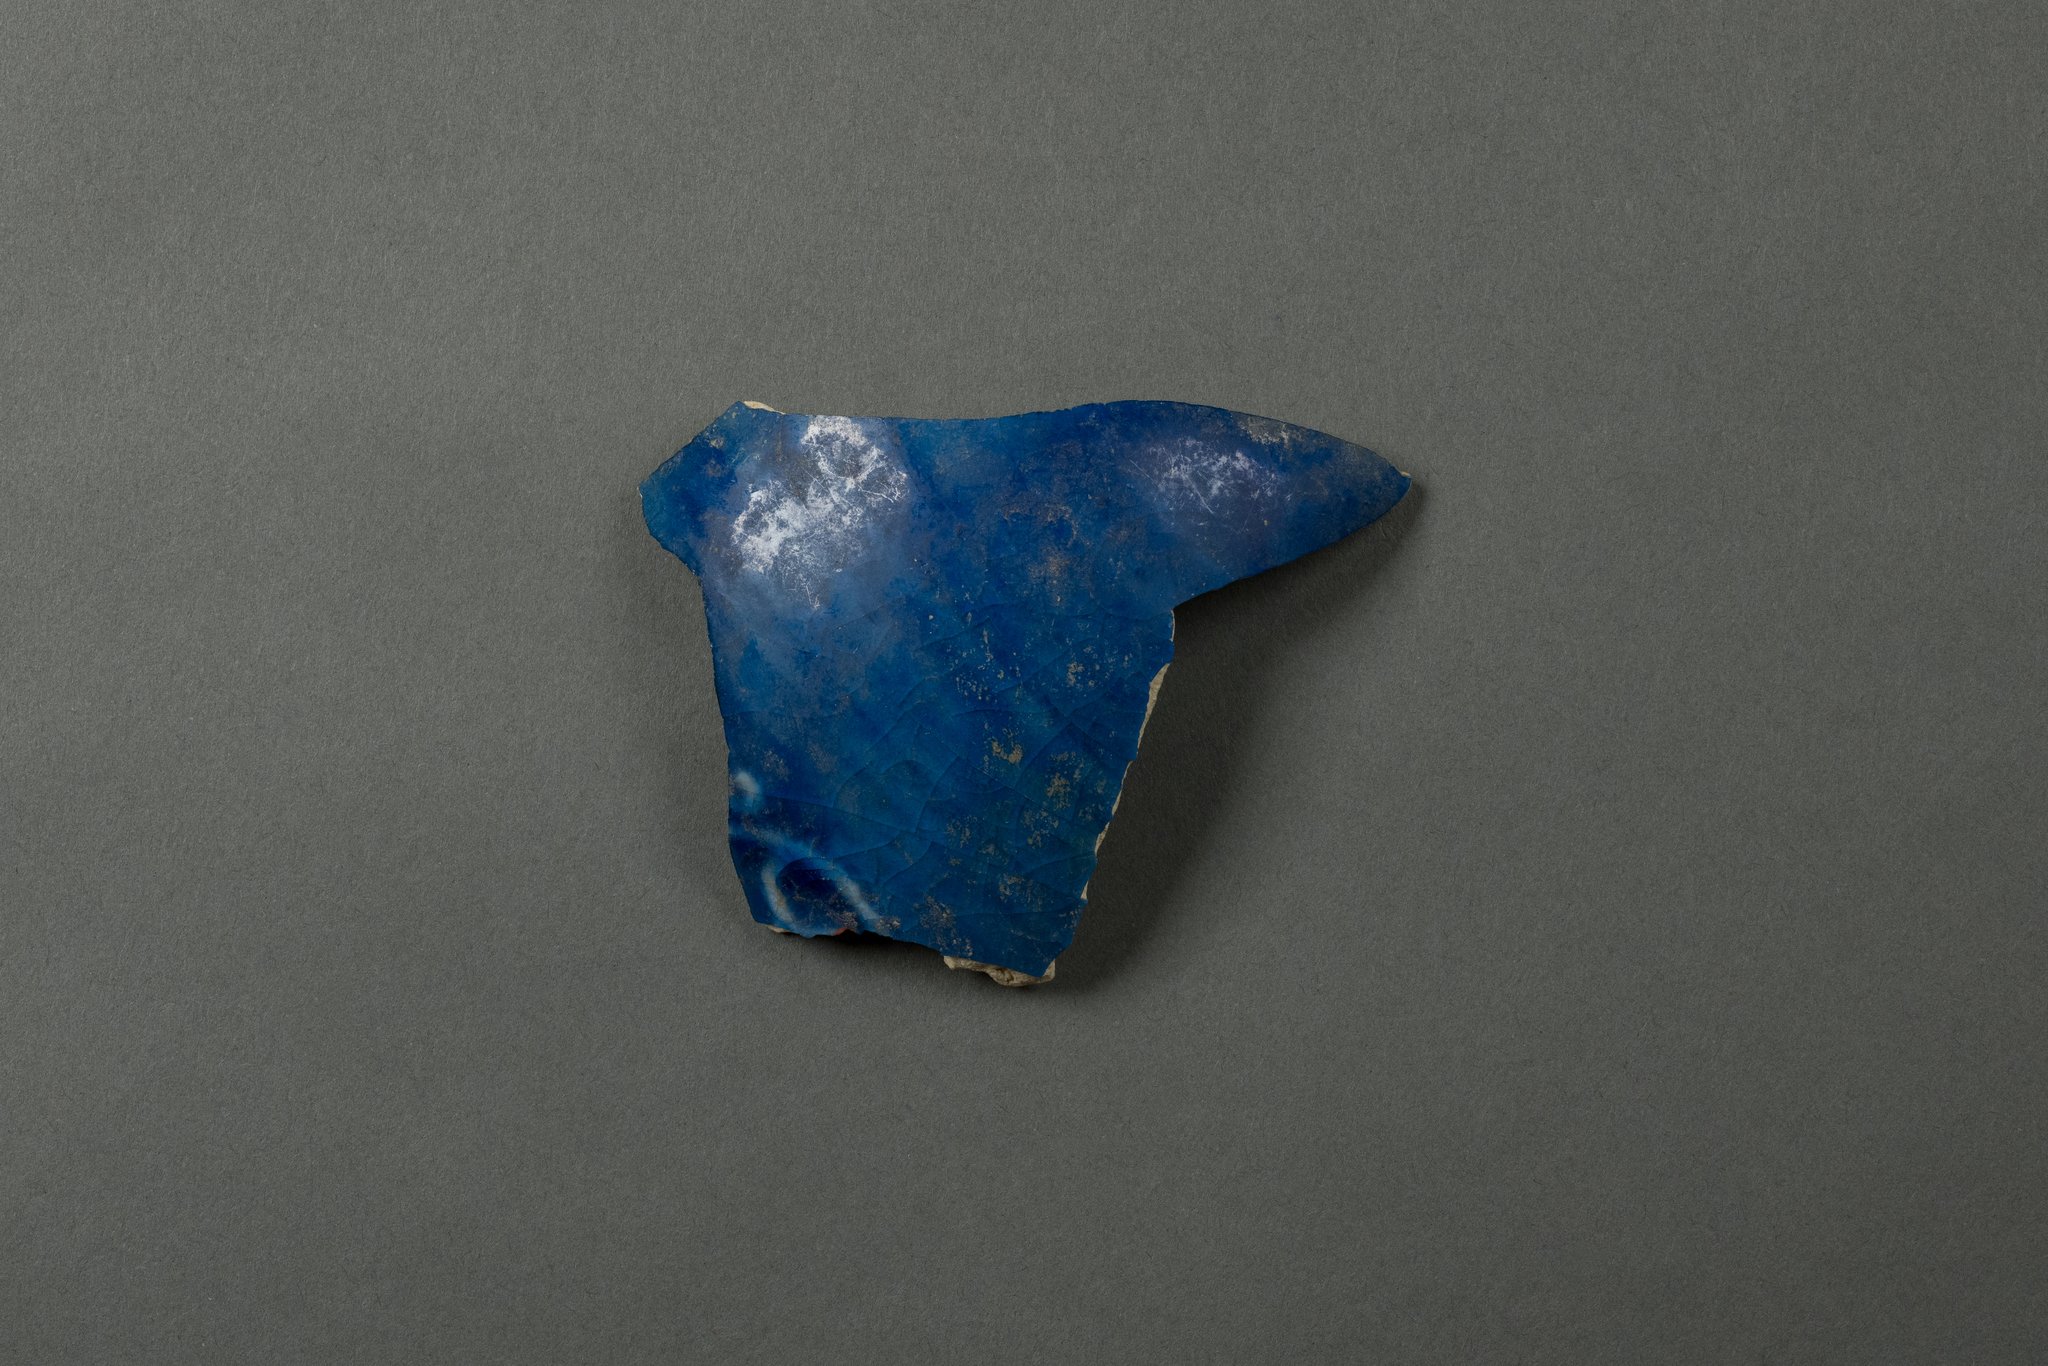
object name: fragment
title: Ceramic Fragment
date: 1001-1200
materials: earthenware, glaze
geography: iran